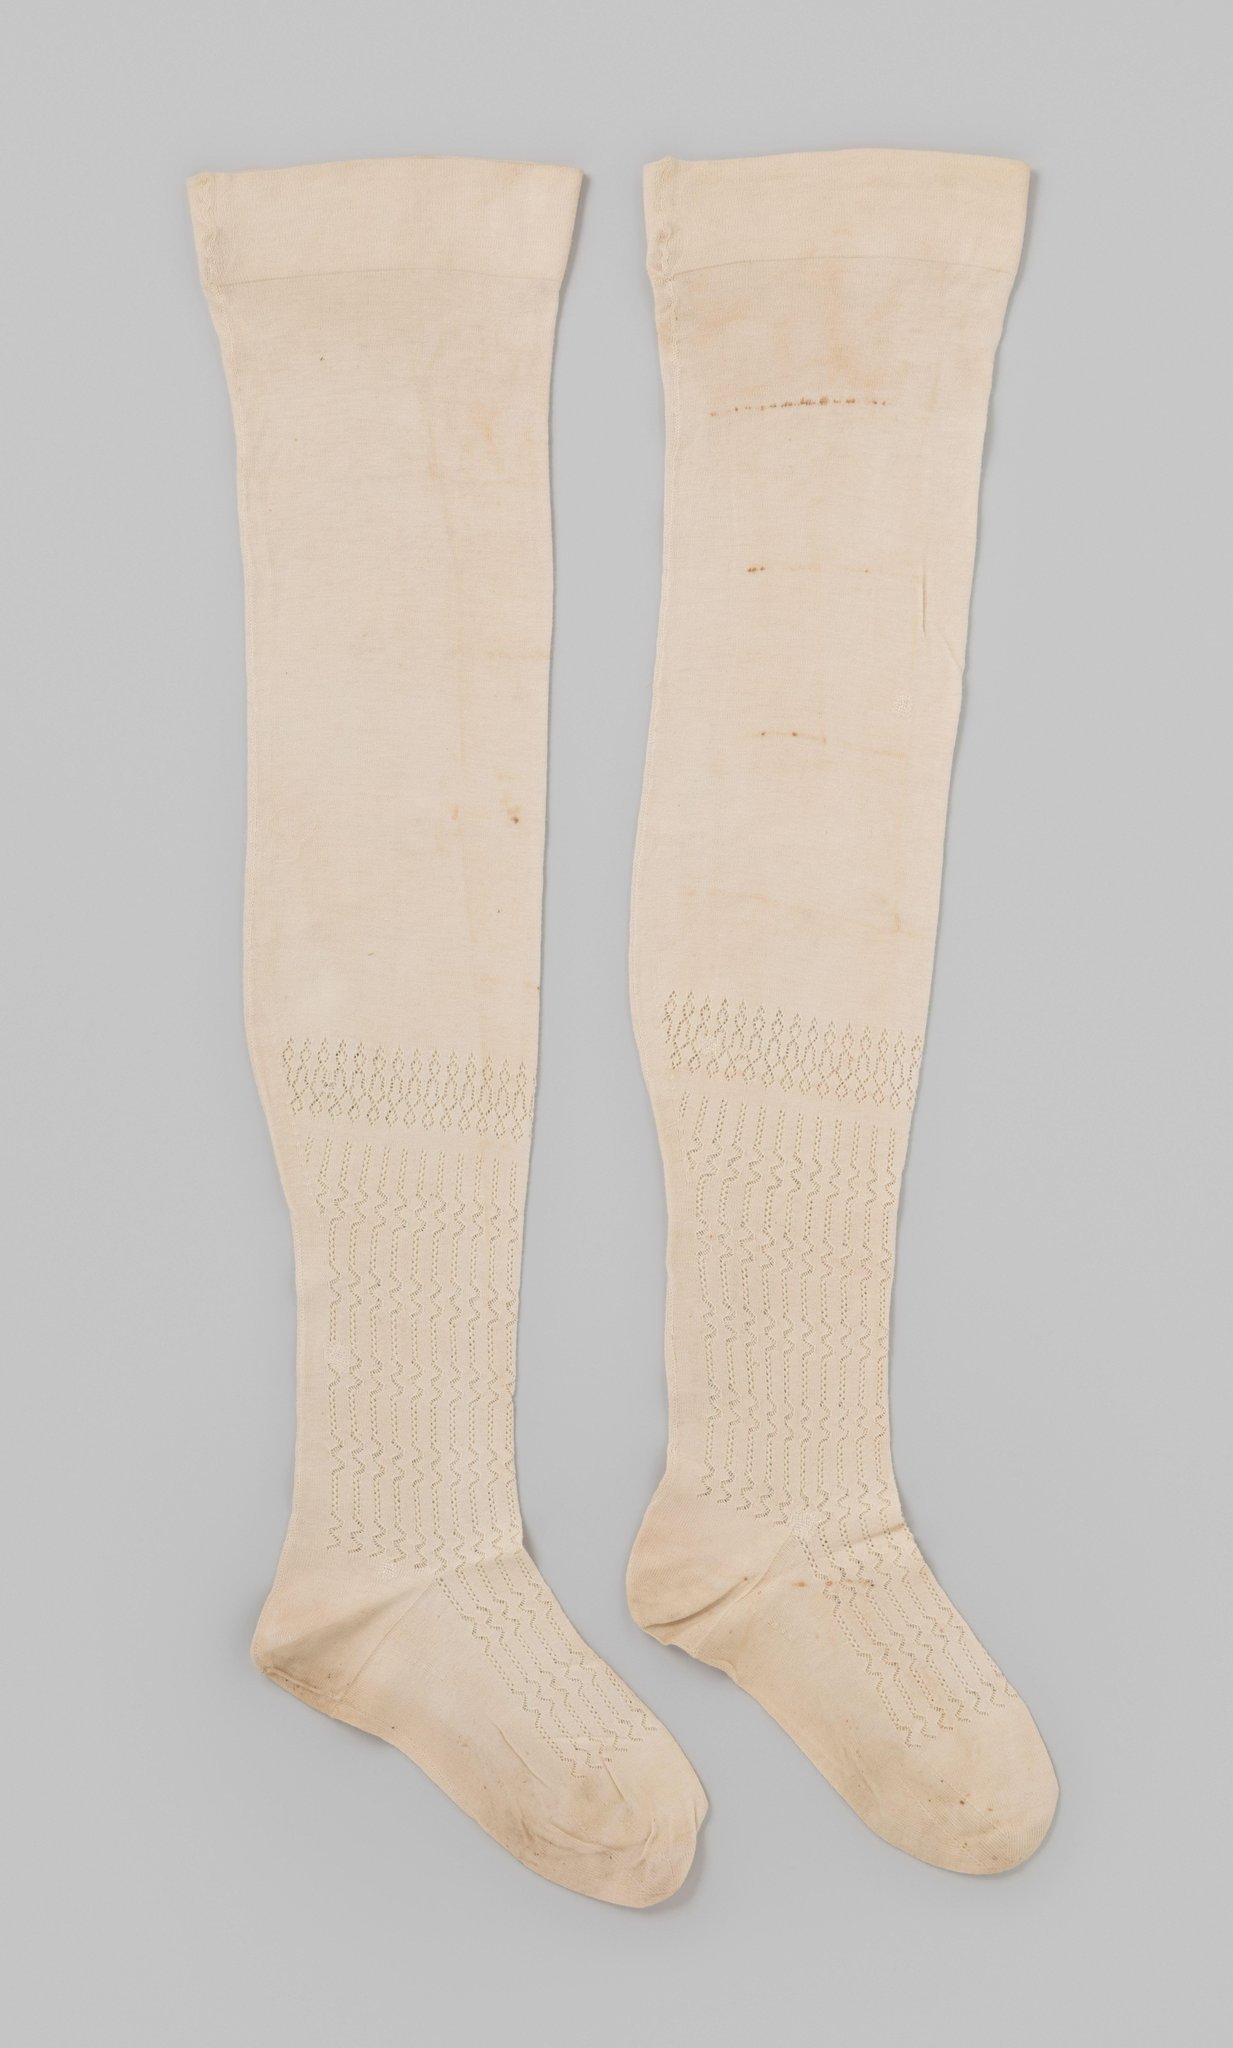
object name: stocking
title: Kous van witte katoenen tricot met ajour gebreide klink van strepen en golvenpatroon en effen kuitdeel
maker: Anonymous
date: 1910-1915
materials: cotton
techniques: embroidery, knitting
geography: netherlands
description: Kous, deel van een paar, van witte katoenen tricot. Met naad en zeer smal boordje. Vanaf de kuit en over het gehele been ingebreide streepjes, onderbroken door golfjes. Fries van fijne balusters met puntjes.